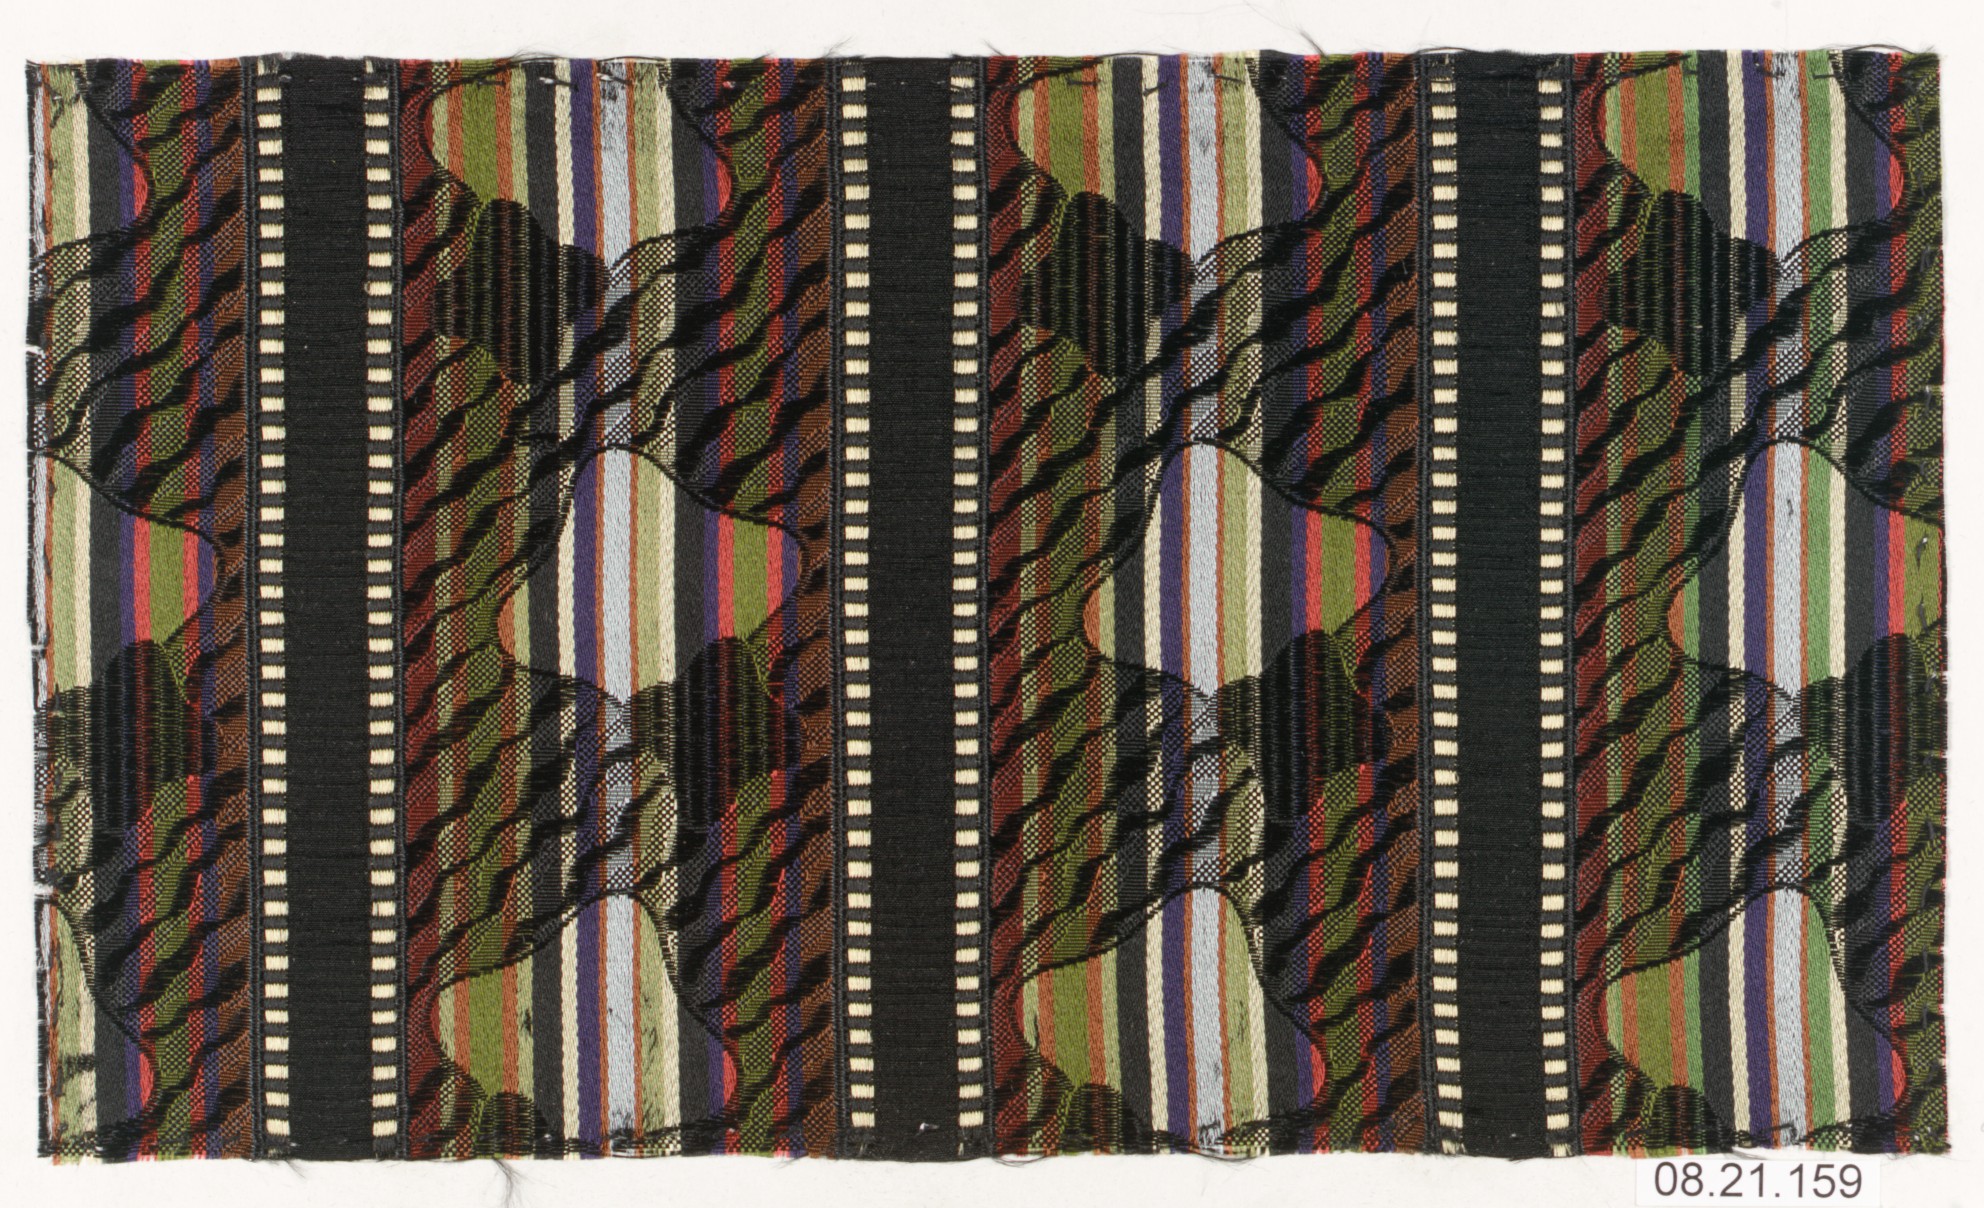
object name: textile sample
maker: Anonymous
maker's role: designer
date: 1900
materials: silk